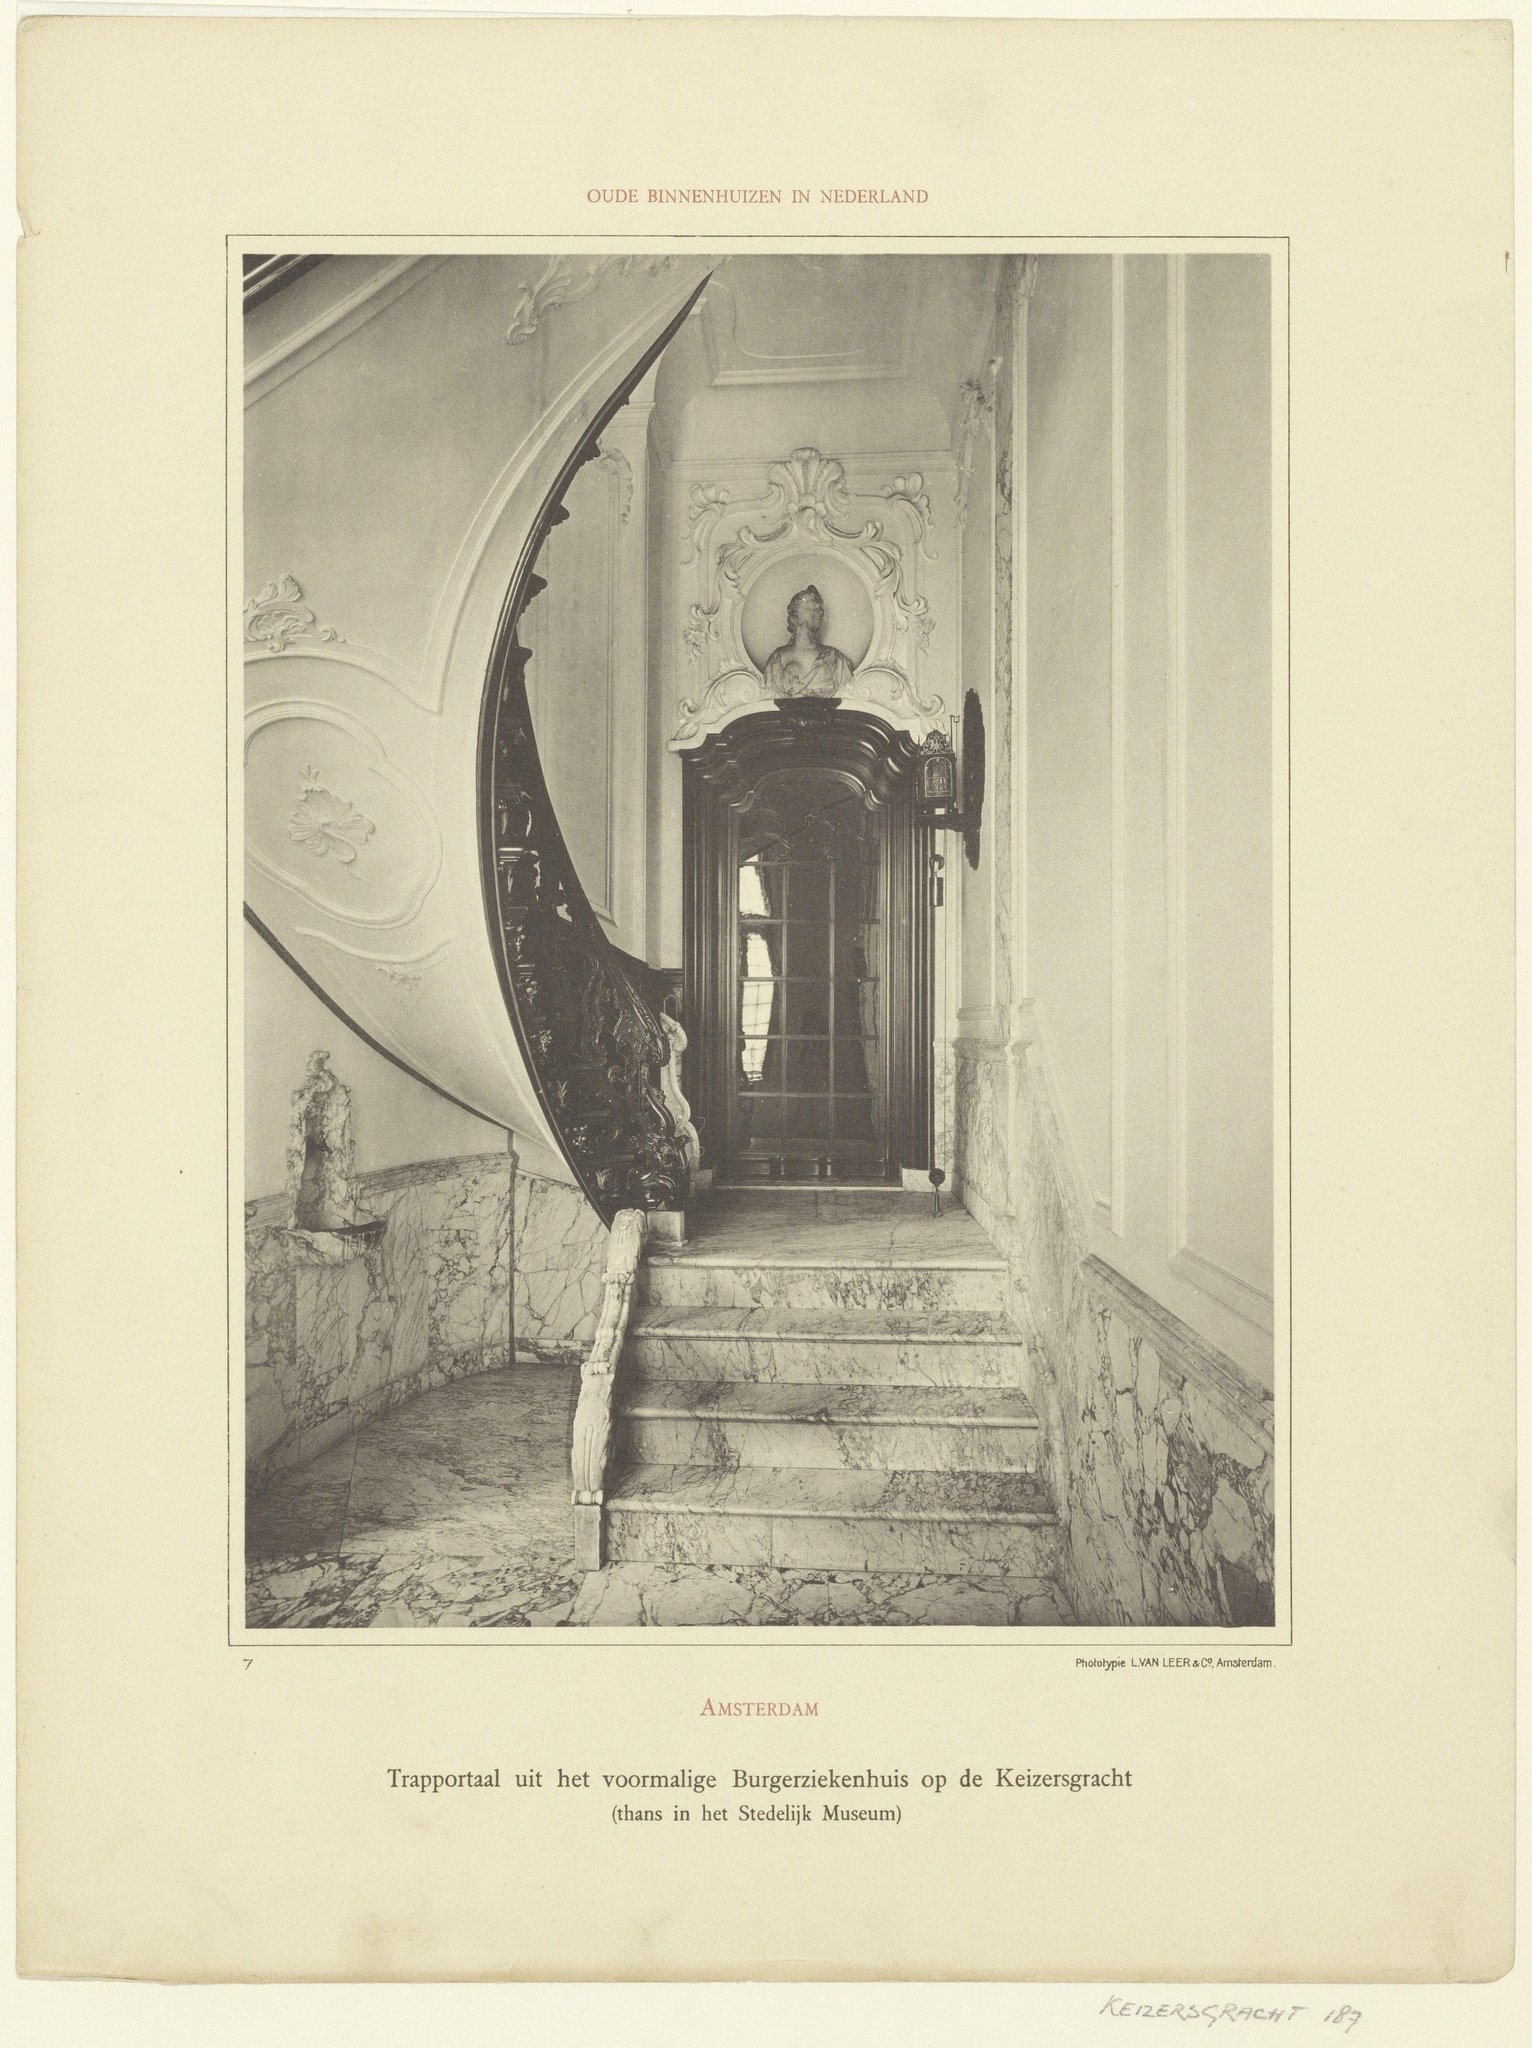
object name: architectural element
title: Onderdelen van het trapportaal uit het pand aan de Keizersgracht 187 te Amsterdam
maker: Anonymous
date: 1740-1760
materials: wood, marble